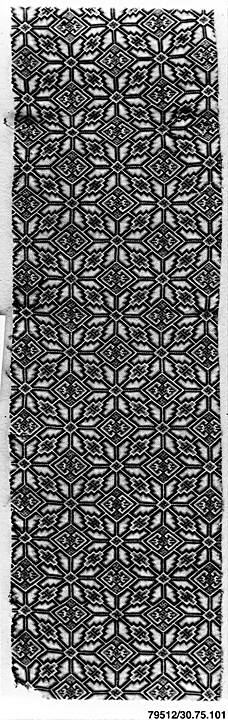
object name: piece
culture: chinese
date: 1701-1800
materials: silk